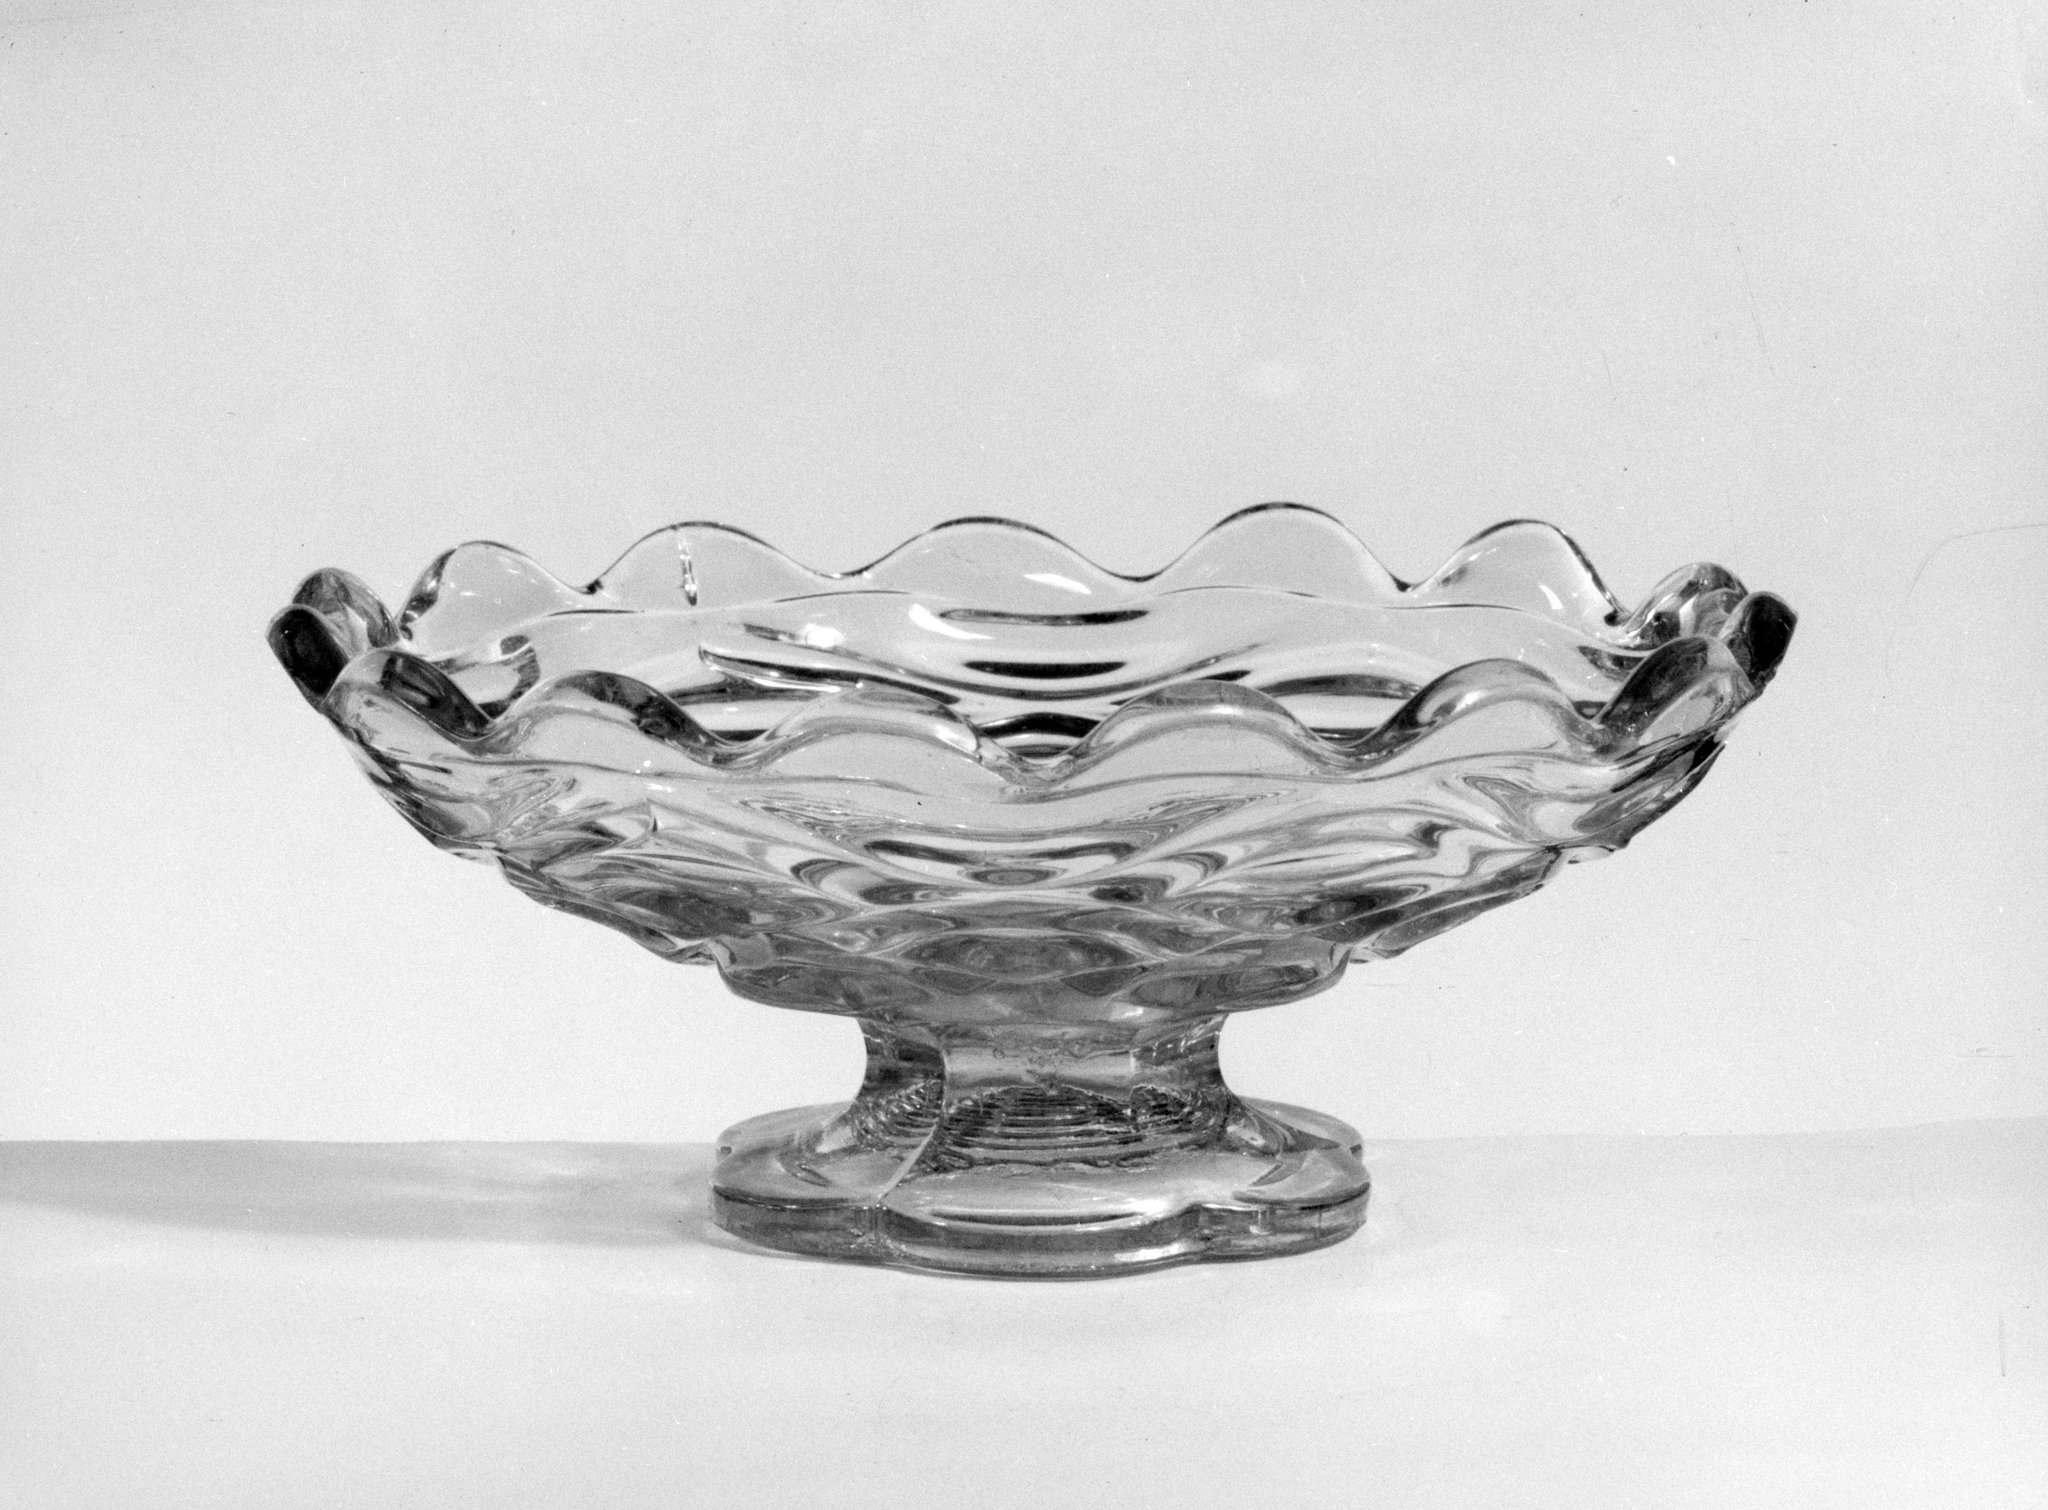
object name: bowl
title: Footed Bowl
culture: american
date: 1850-1870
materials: glass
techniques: pressed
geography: united states